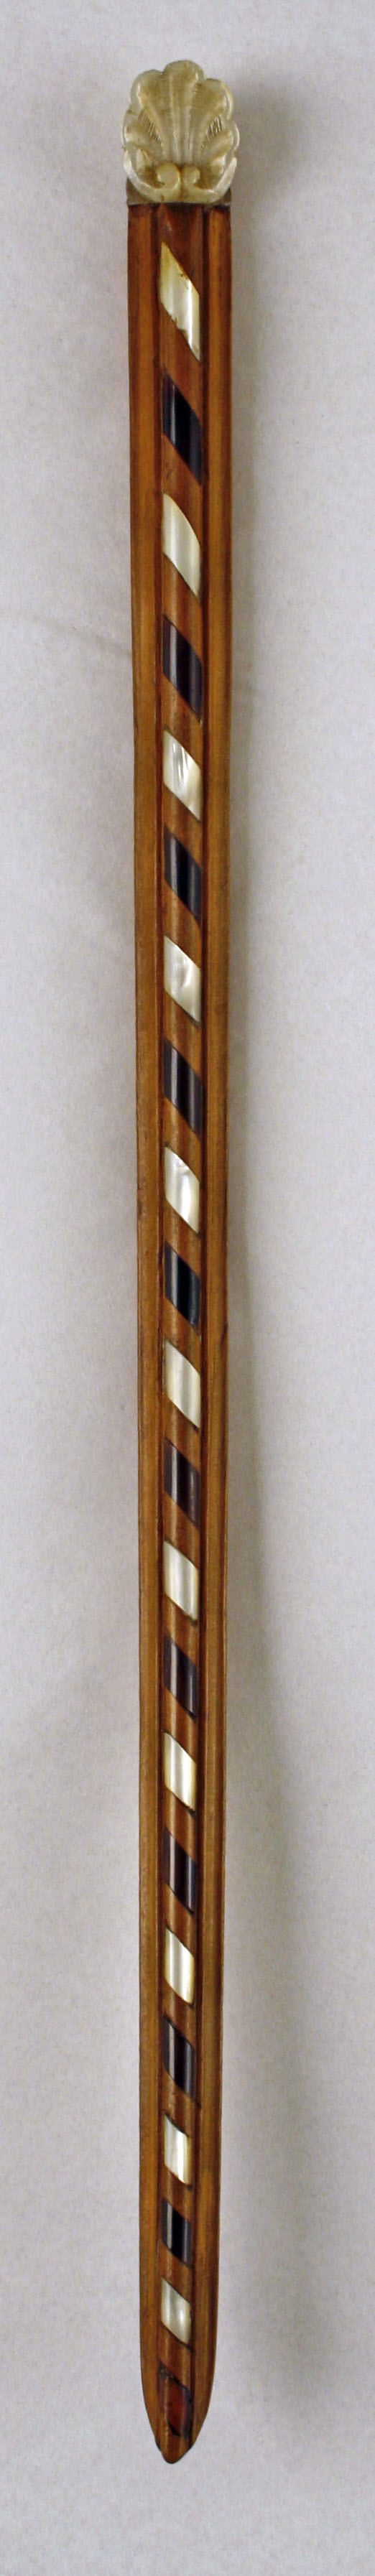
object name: busk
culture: italian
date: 1701-1800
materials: horn, shell, wood